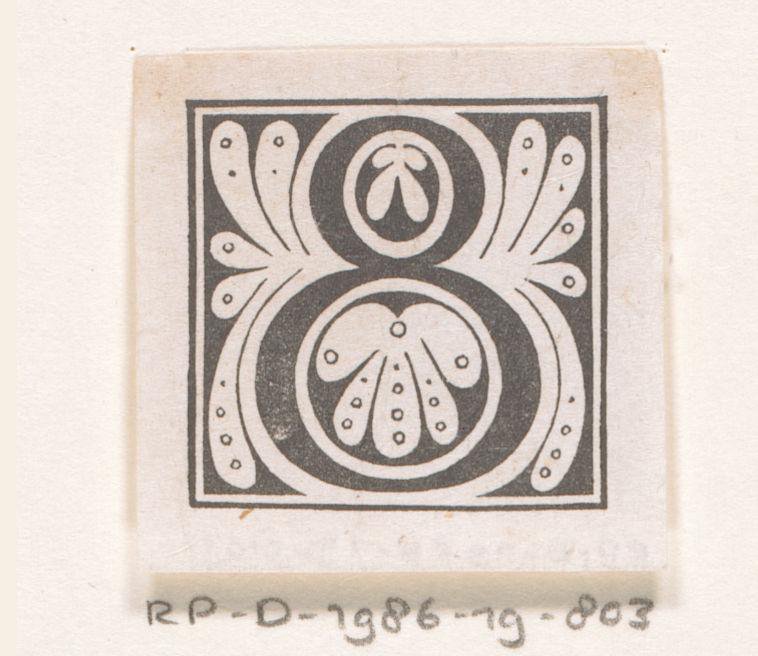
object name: photomechanical print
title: Getal 8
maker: reinier willem petrus de vries (1874-1953)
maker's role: draughtsman, print maker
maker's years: 1874-1953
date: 1904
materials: paper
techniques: printing block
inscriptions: collector's mark: ‘R:MVS.’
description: Het getal is gebruikt voor: Veth, Jan. Jozef Israëls en zijn kunst. Arnhem en Nijmegen: Gebroeders E&M Cohen, 1904.